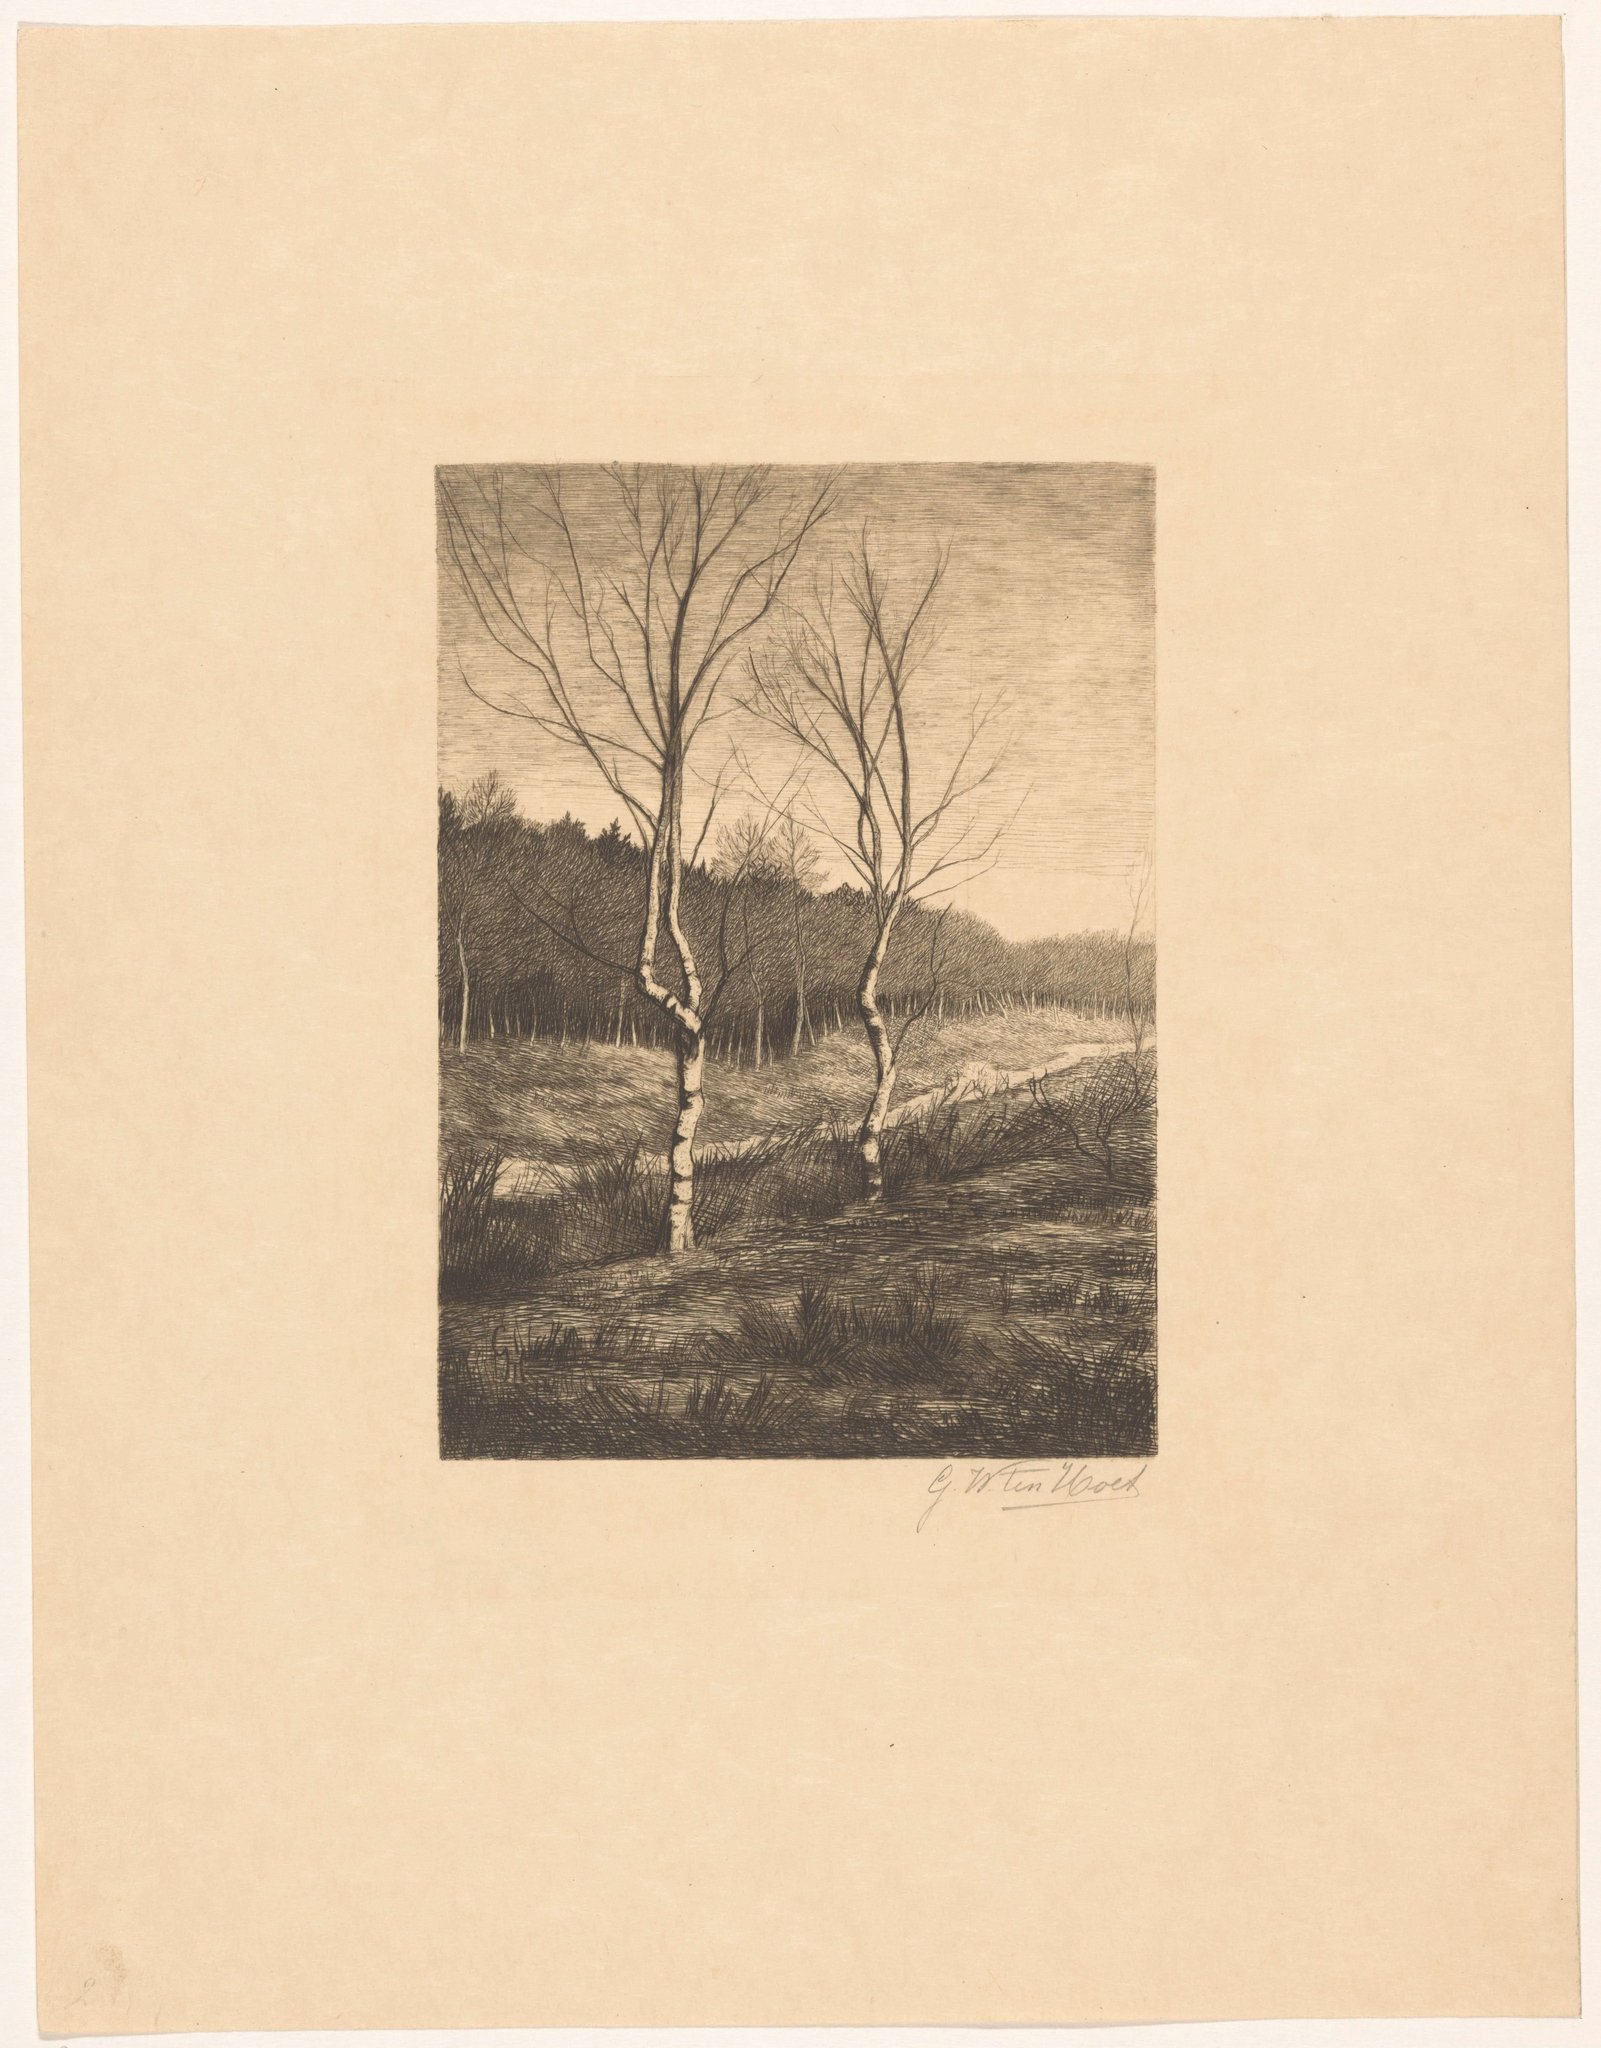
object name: print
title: Berkjes in de winter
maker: gerarda wilhelmina ten hoet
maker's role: print maker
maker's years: 1857-1939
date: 1867-1939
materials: paper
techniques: etching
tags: fringe, edge of the wood, trees: birch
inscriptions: collector's mark: Lugt 2228